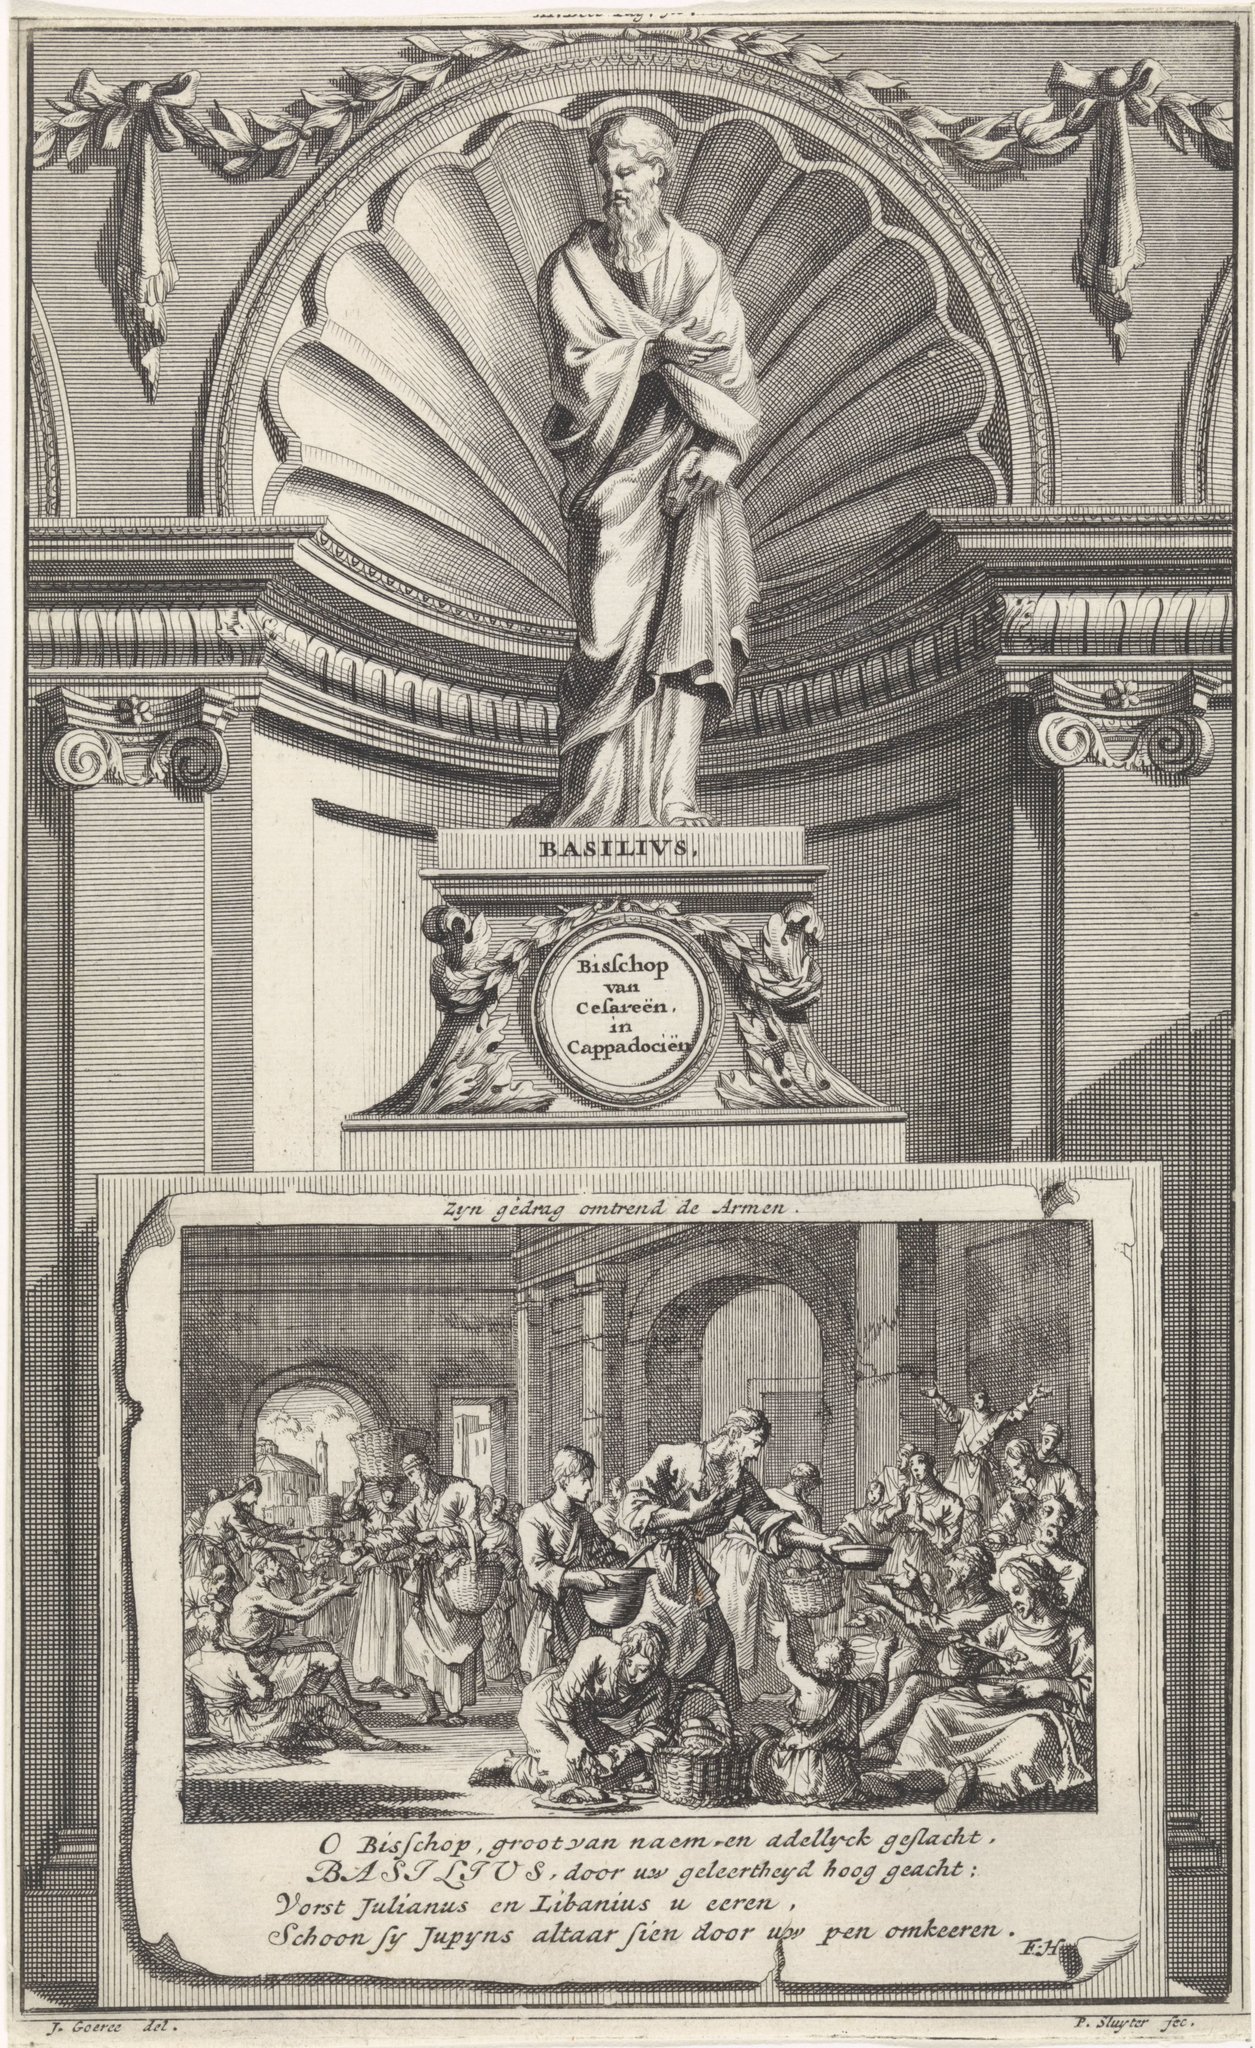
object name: print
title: H. Basilius van Caesarea, kerkvader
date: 1698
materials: paper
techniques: engraving, etching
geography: amsterdam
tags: giving alms or other charity, e.g.: handing out food, basil the great (basilius magnus), bishop of caesarea; possible attributes: dove, (column of) fire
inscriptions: collector's mark: Lugt 2228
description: De heilige kerkvader Basilius van Caesarea, staand op een sokkel. Op de voorzijde de scène waarin Basilius voedsel uitdeelt aan de armen. Prent middenboven gemerkt: III. Deel Pag. 311 (voor overgrote deel afgesneden).